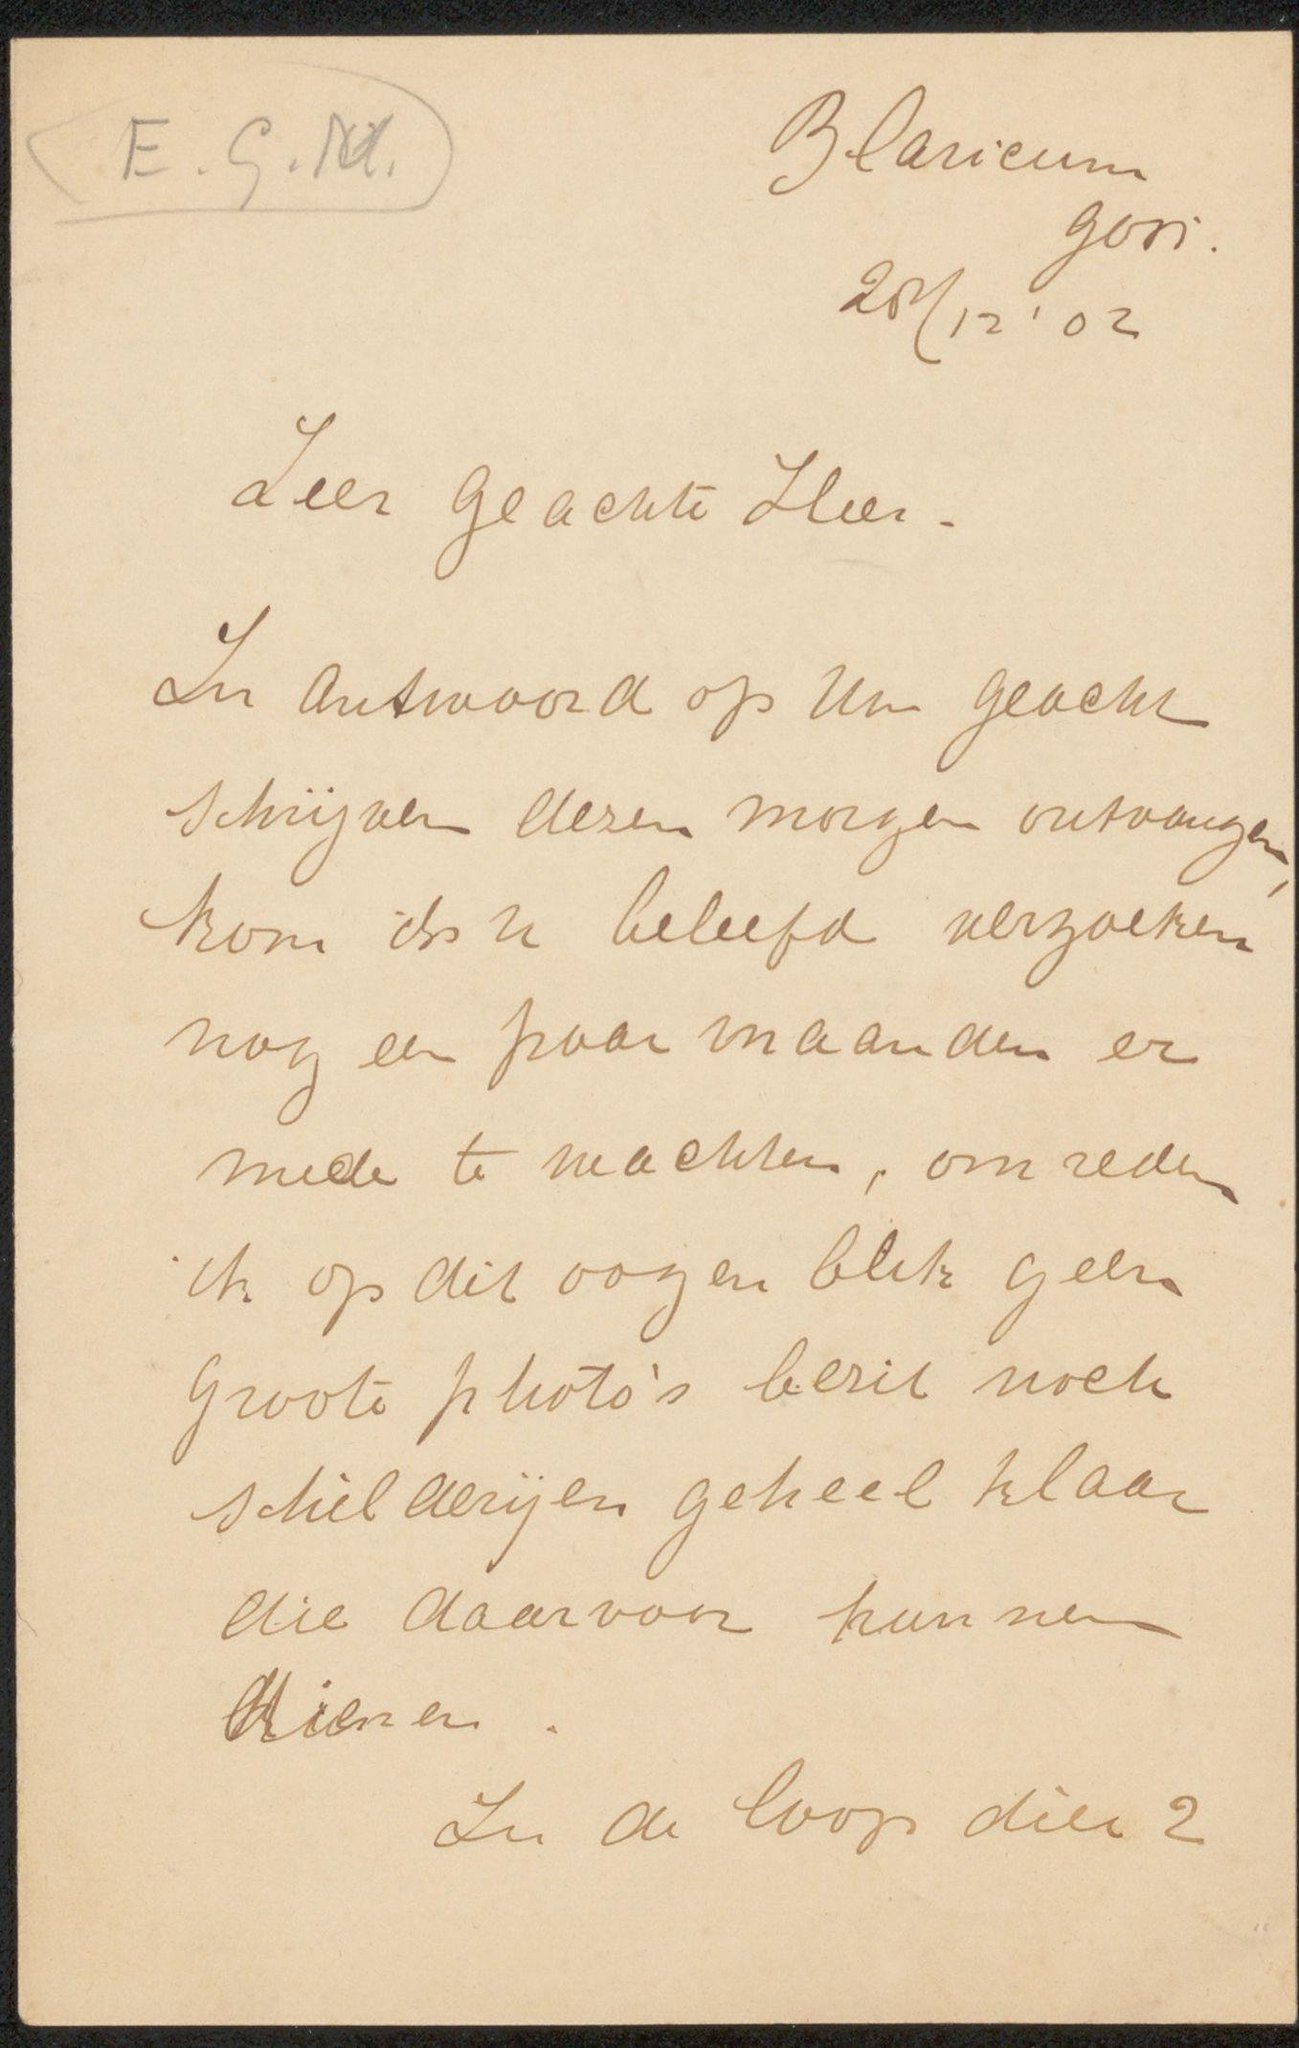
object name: letter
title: Brief aan Philip Zilcken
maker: evert pieters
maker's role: draughtsman, painter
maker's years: 1856-1932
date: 1902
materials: ink, paper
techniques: pen, writing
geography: blaricum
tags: painter, draughtsman, philip zilcken, photography, cinematography, painting (including book-illumination, miniature-painting), workshop, studio of the artist (in general), the hague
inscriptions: collector's mark: ‘RPK’